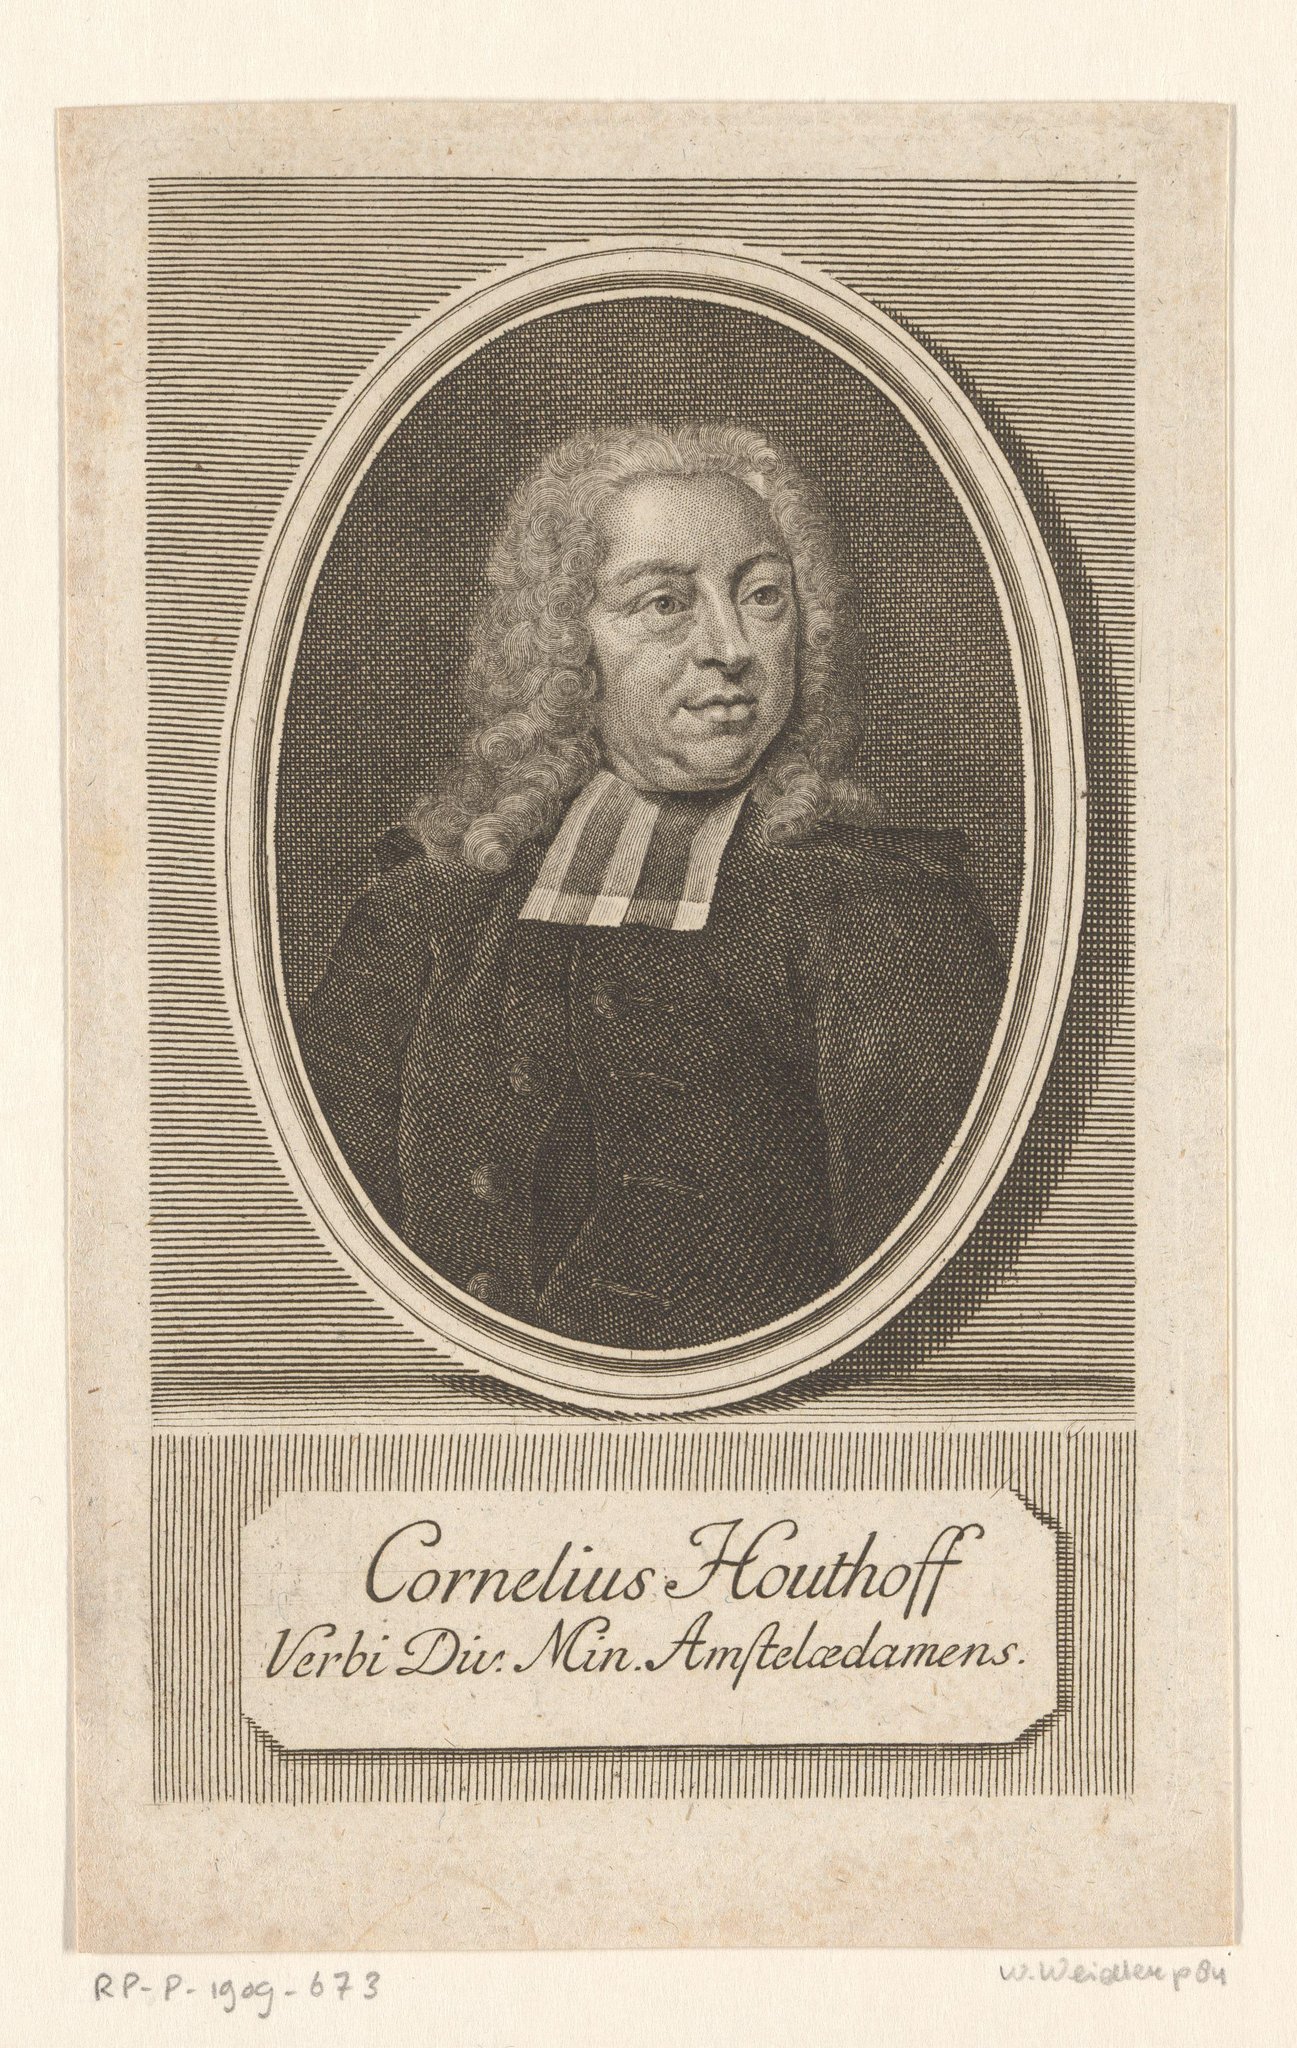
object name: print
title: Portret van Cornelis Houthoff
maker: johann martin bernigeroth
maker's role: print maker, publisher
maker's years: 1713-1767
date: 1745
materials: paper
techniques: engraving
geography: leipzig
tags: amsterdam, historical persons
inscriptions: collector's mark: Lugt 2228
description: Prent ook gebruikt in: Zuverlässige Nachrichten von dem gegenwärtigen Zustande, Veränderung und Wachsthum der Wissenschaften. dl. 62. Leipzig: Johann Friedrich Gleditsch, 1745.